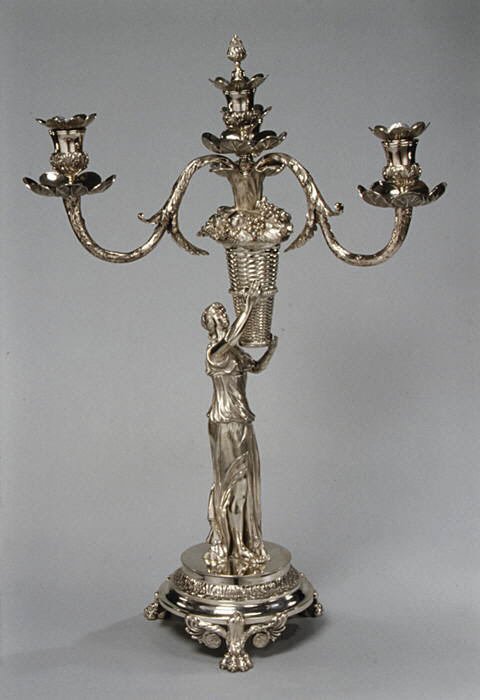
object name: candelabrum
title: Pair of three-light candelabra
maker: william pitts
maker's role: maker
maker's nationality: british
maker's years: 1790-1840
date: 1808-1809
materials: silver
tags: women